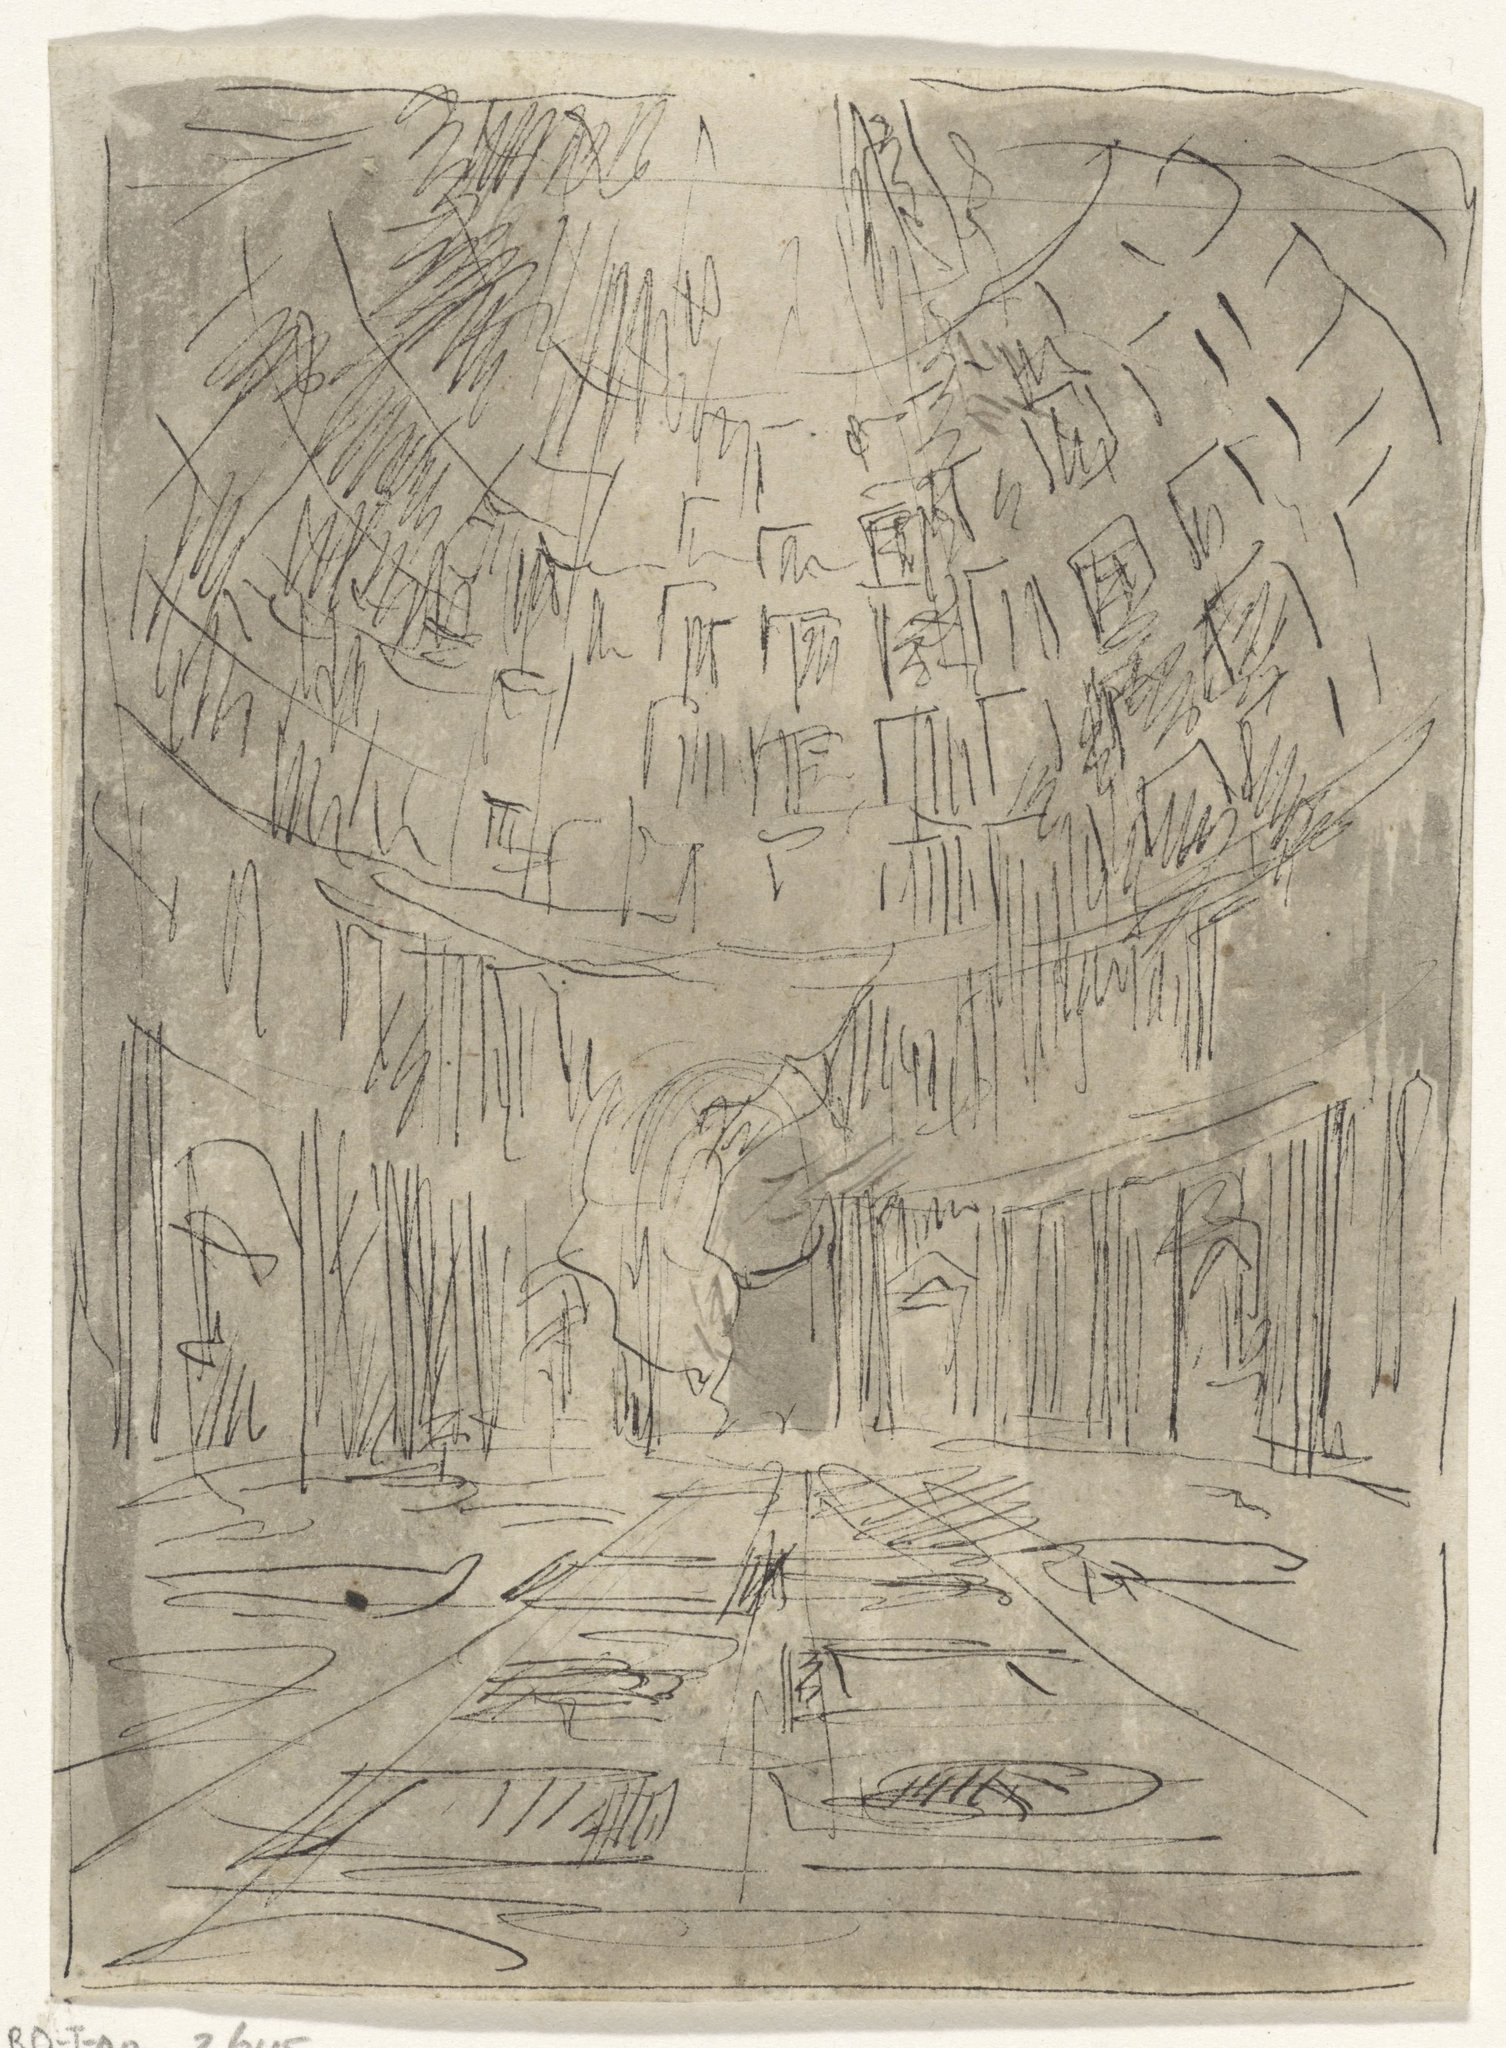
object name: drawing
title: Interieur van het Pantheon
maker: thomas cool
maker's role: draughtsman, painter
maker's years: 1851-1904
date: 1861-1904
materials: ink, paper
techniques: brush, pen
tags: landscape with ruins, temple, shrine ~ non-christian religions, interior ~ representation of a building